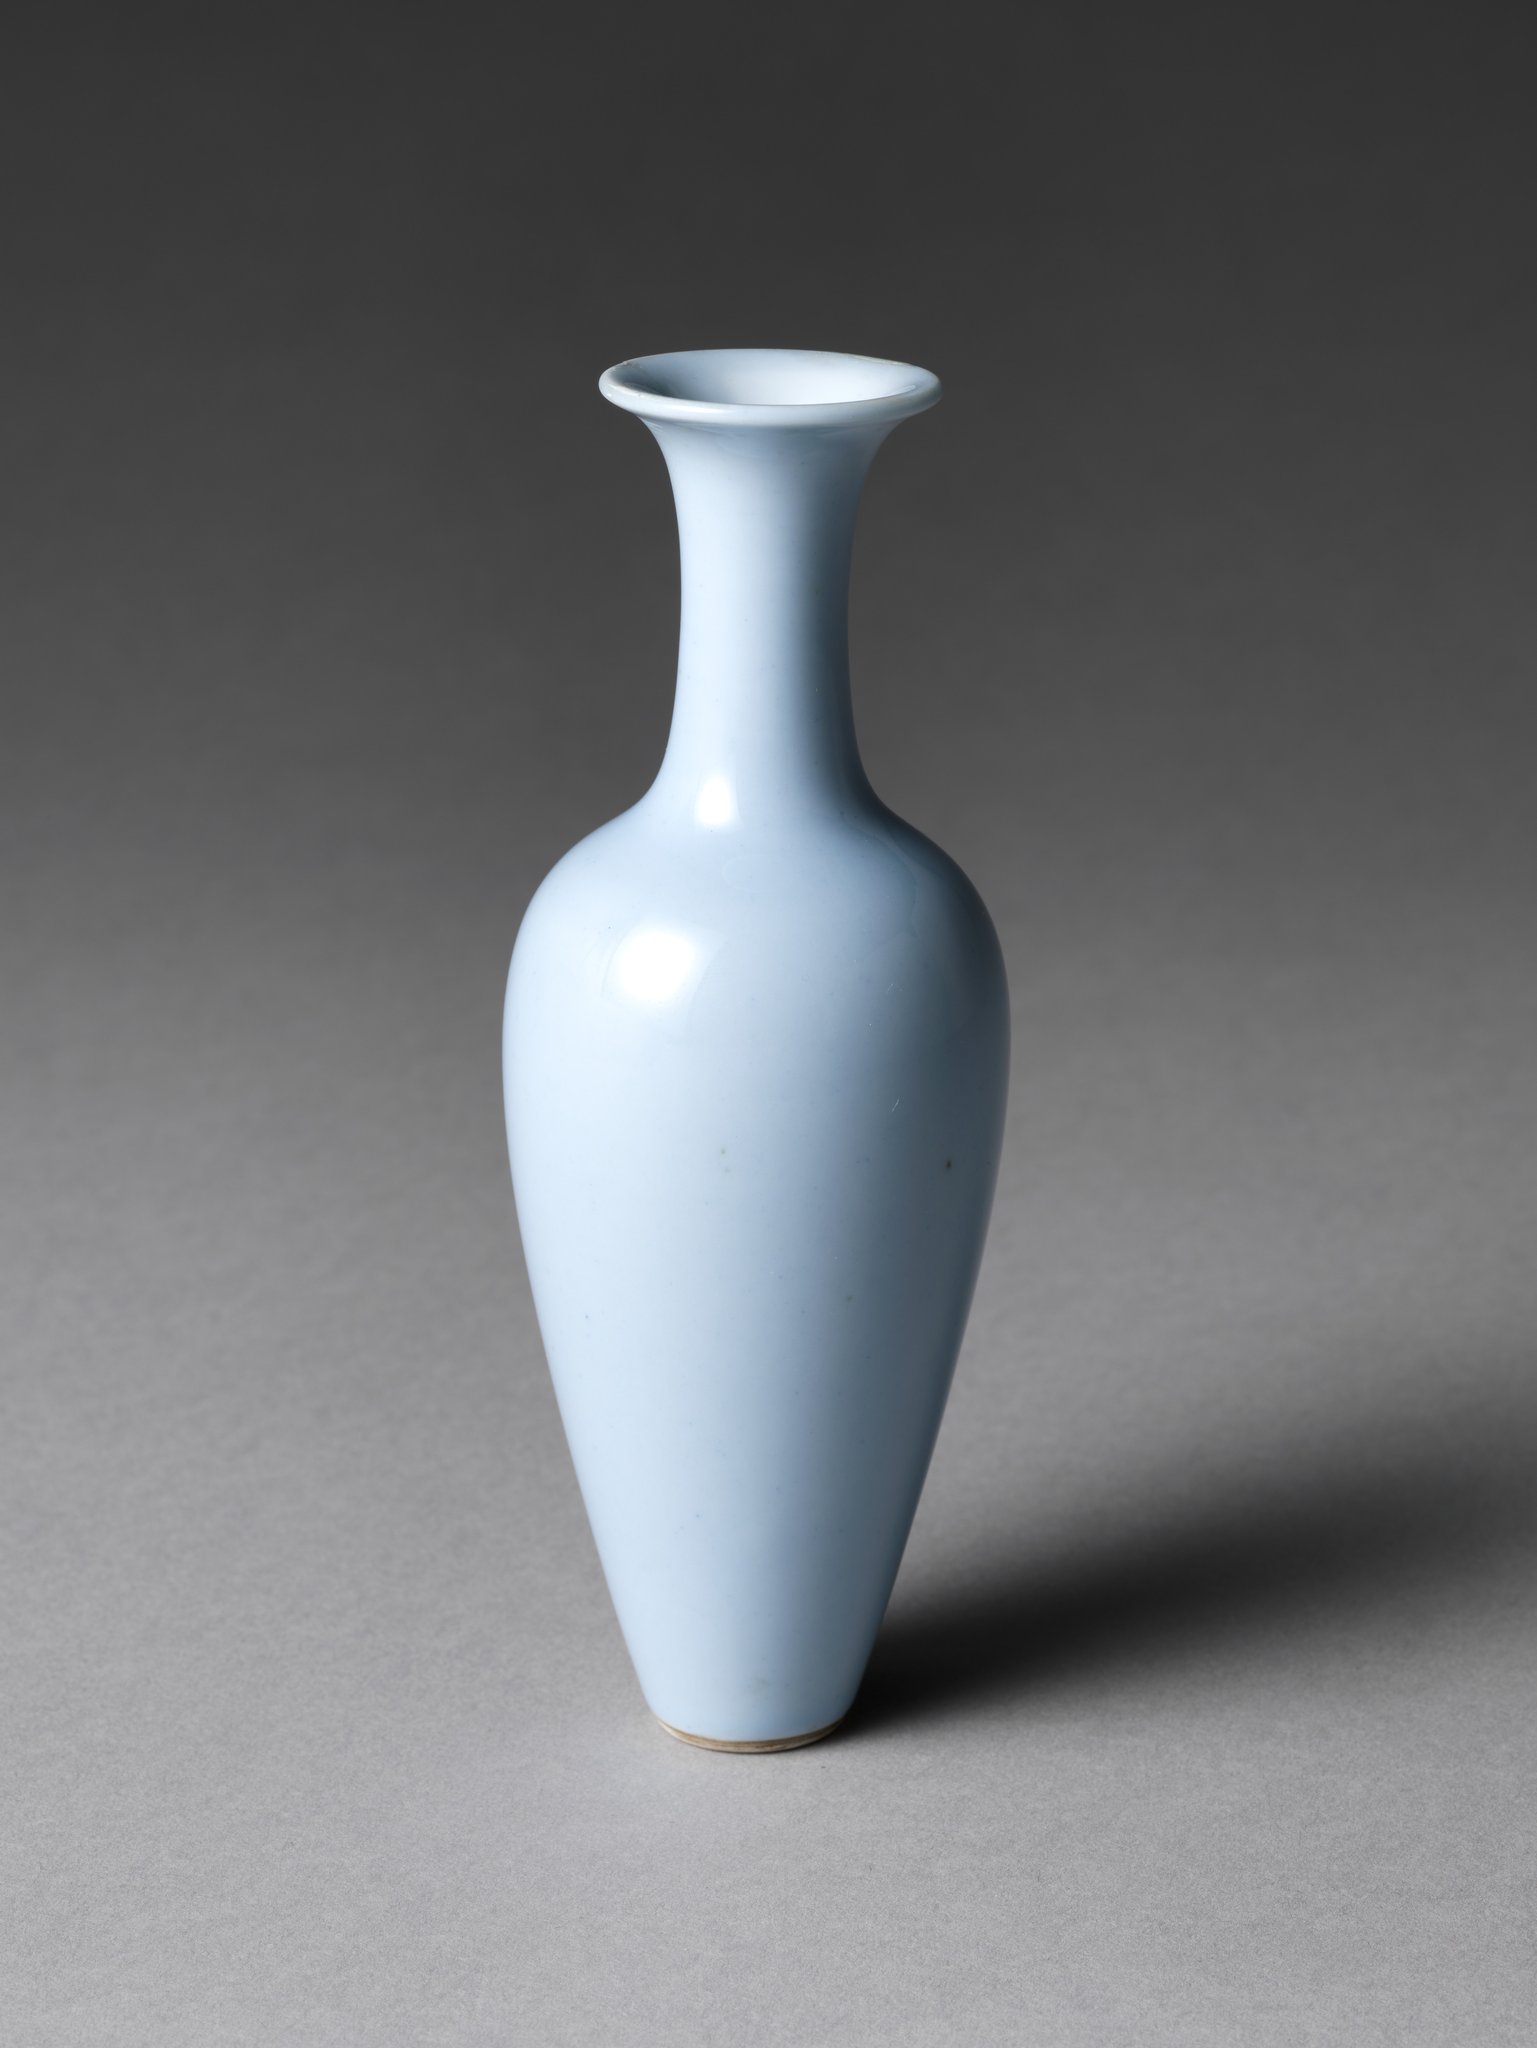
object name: vase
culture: chinese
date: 1678-1688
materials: glaze, porcelain